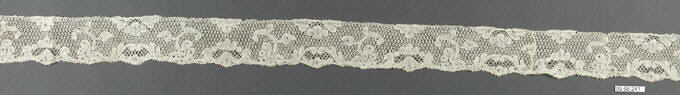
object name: strip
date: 1701-1733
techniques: lace